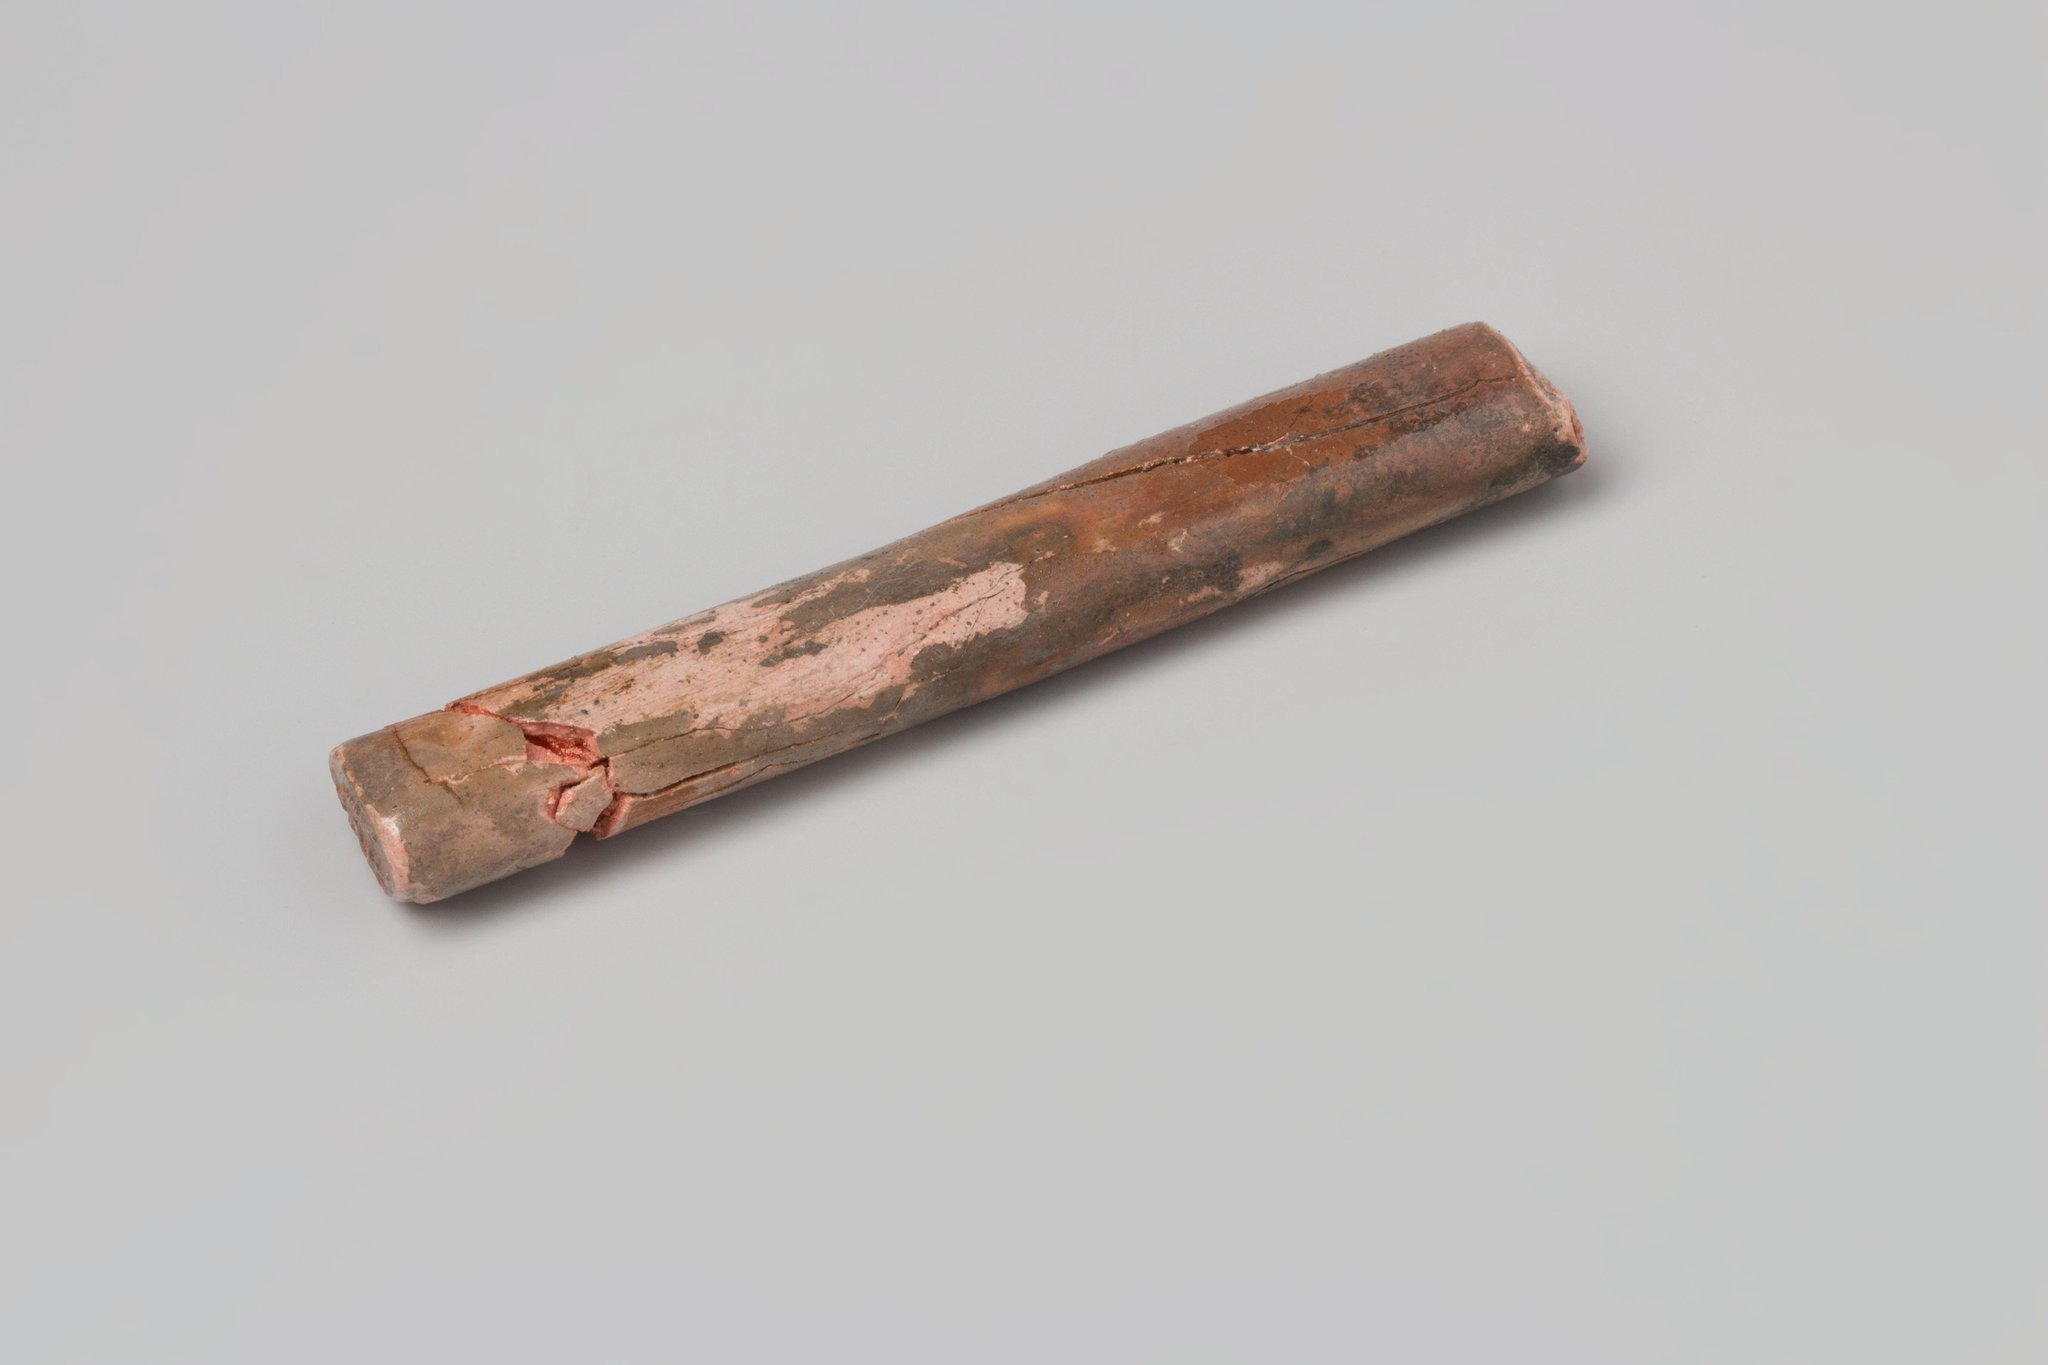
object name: sealing wax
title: Staaf zegellak uit het wrak van de Oost-Indiëvaarder 't Vliegend Hart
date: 1700-1735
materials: wax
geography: netherlands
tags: 't vliegend hart (schip), verenigde oostindische compagnie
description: Staaf zegellak rozerood van kleur met aan éen uiteinde de afdruk van een zegel: onder een kroontje staat 'prince// ....[onleesbaar]'. Sealing wax.